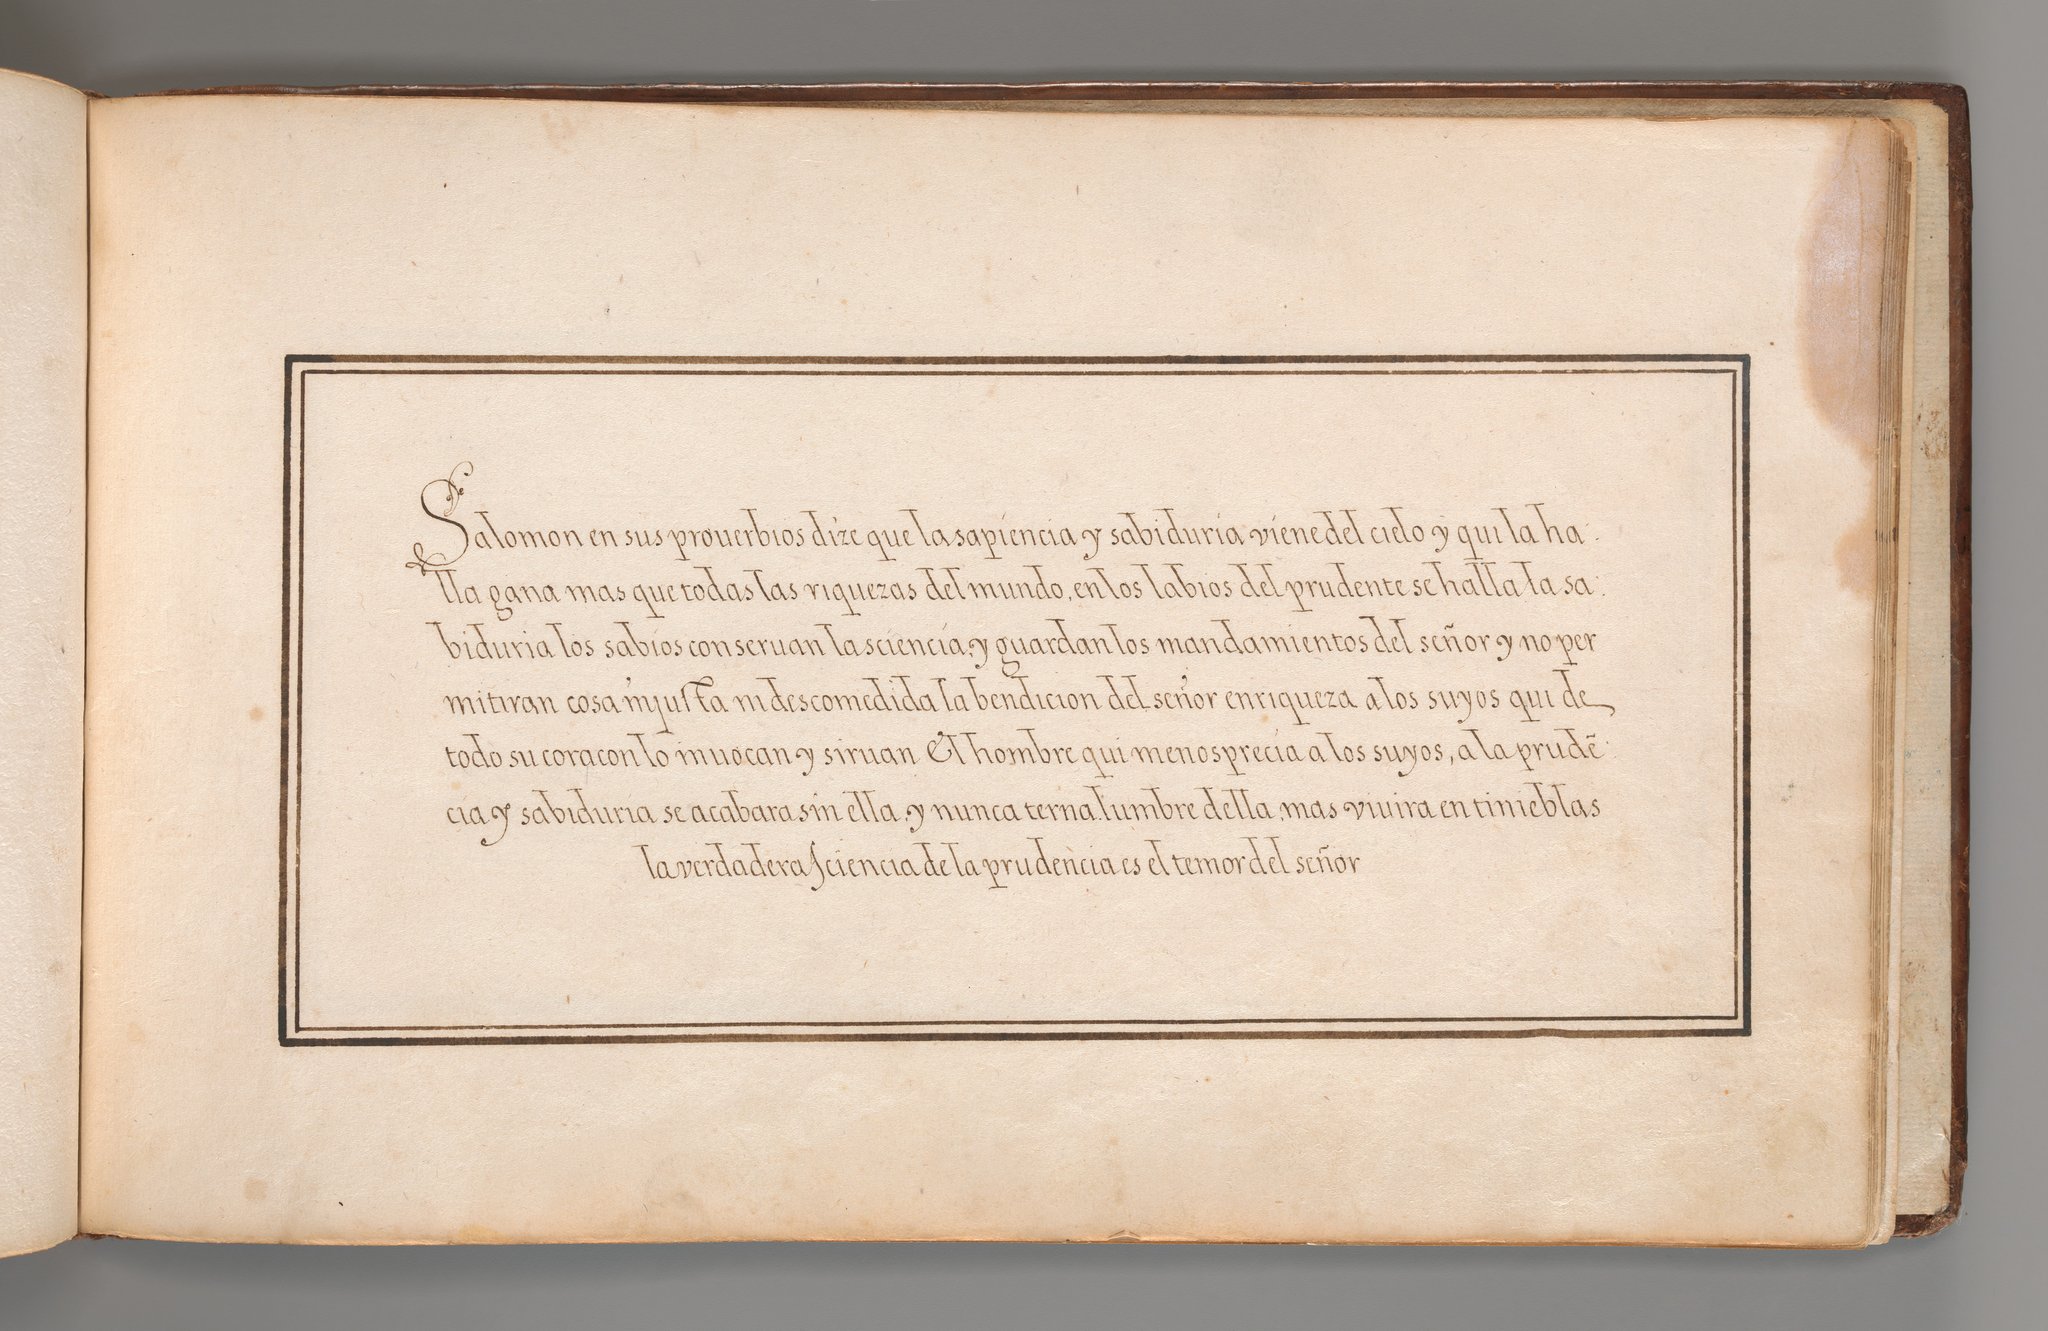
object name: album print ornament architecture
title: Calligraphic Exercise in Spanish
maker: Anonymous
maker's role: artist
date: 1601-1633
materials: ink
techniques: pen